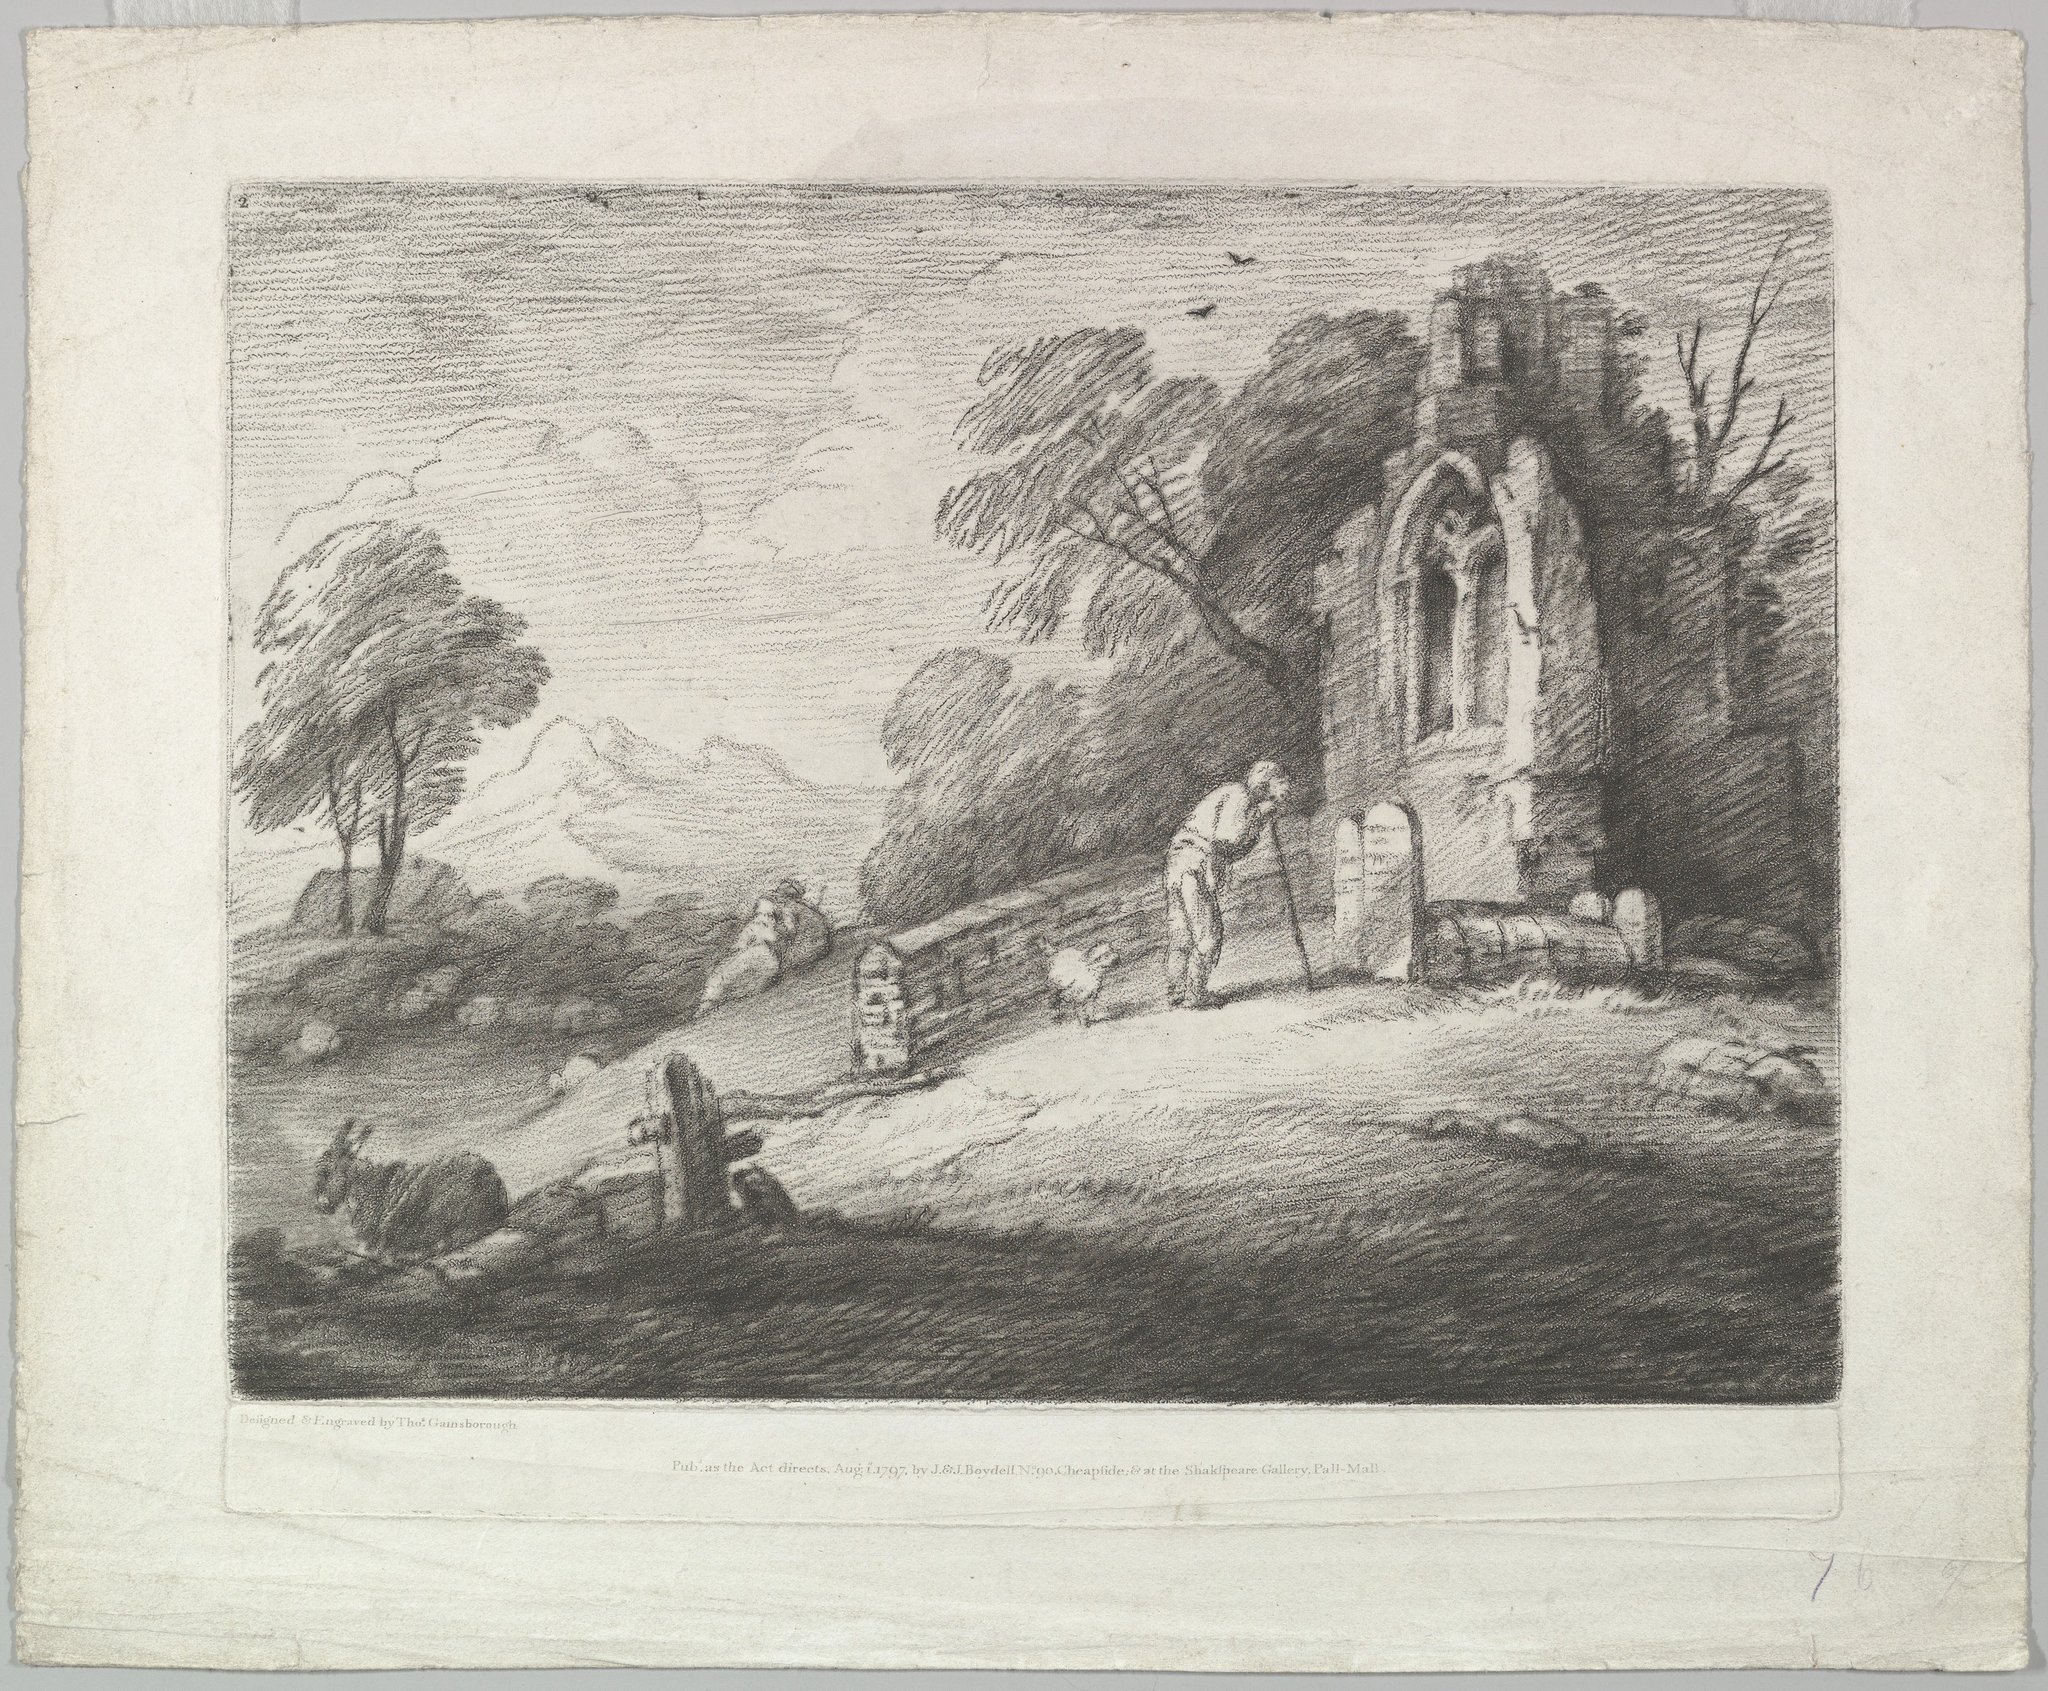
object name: print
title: Wooded Landscape with a Peasant Reading a Tombstone, Rustic Lovers and a Ruined Church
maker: thomas gainsborough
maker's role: artist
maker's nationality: british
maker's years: 1727-1788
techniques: etching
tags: animals,tombs,ruins,men,landscapes